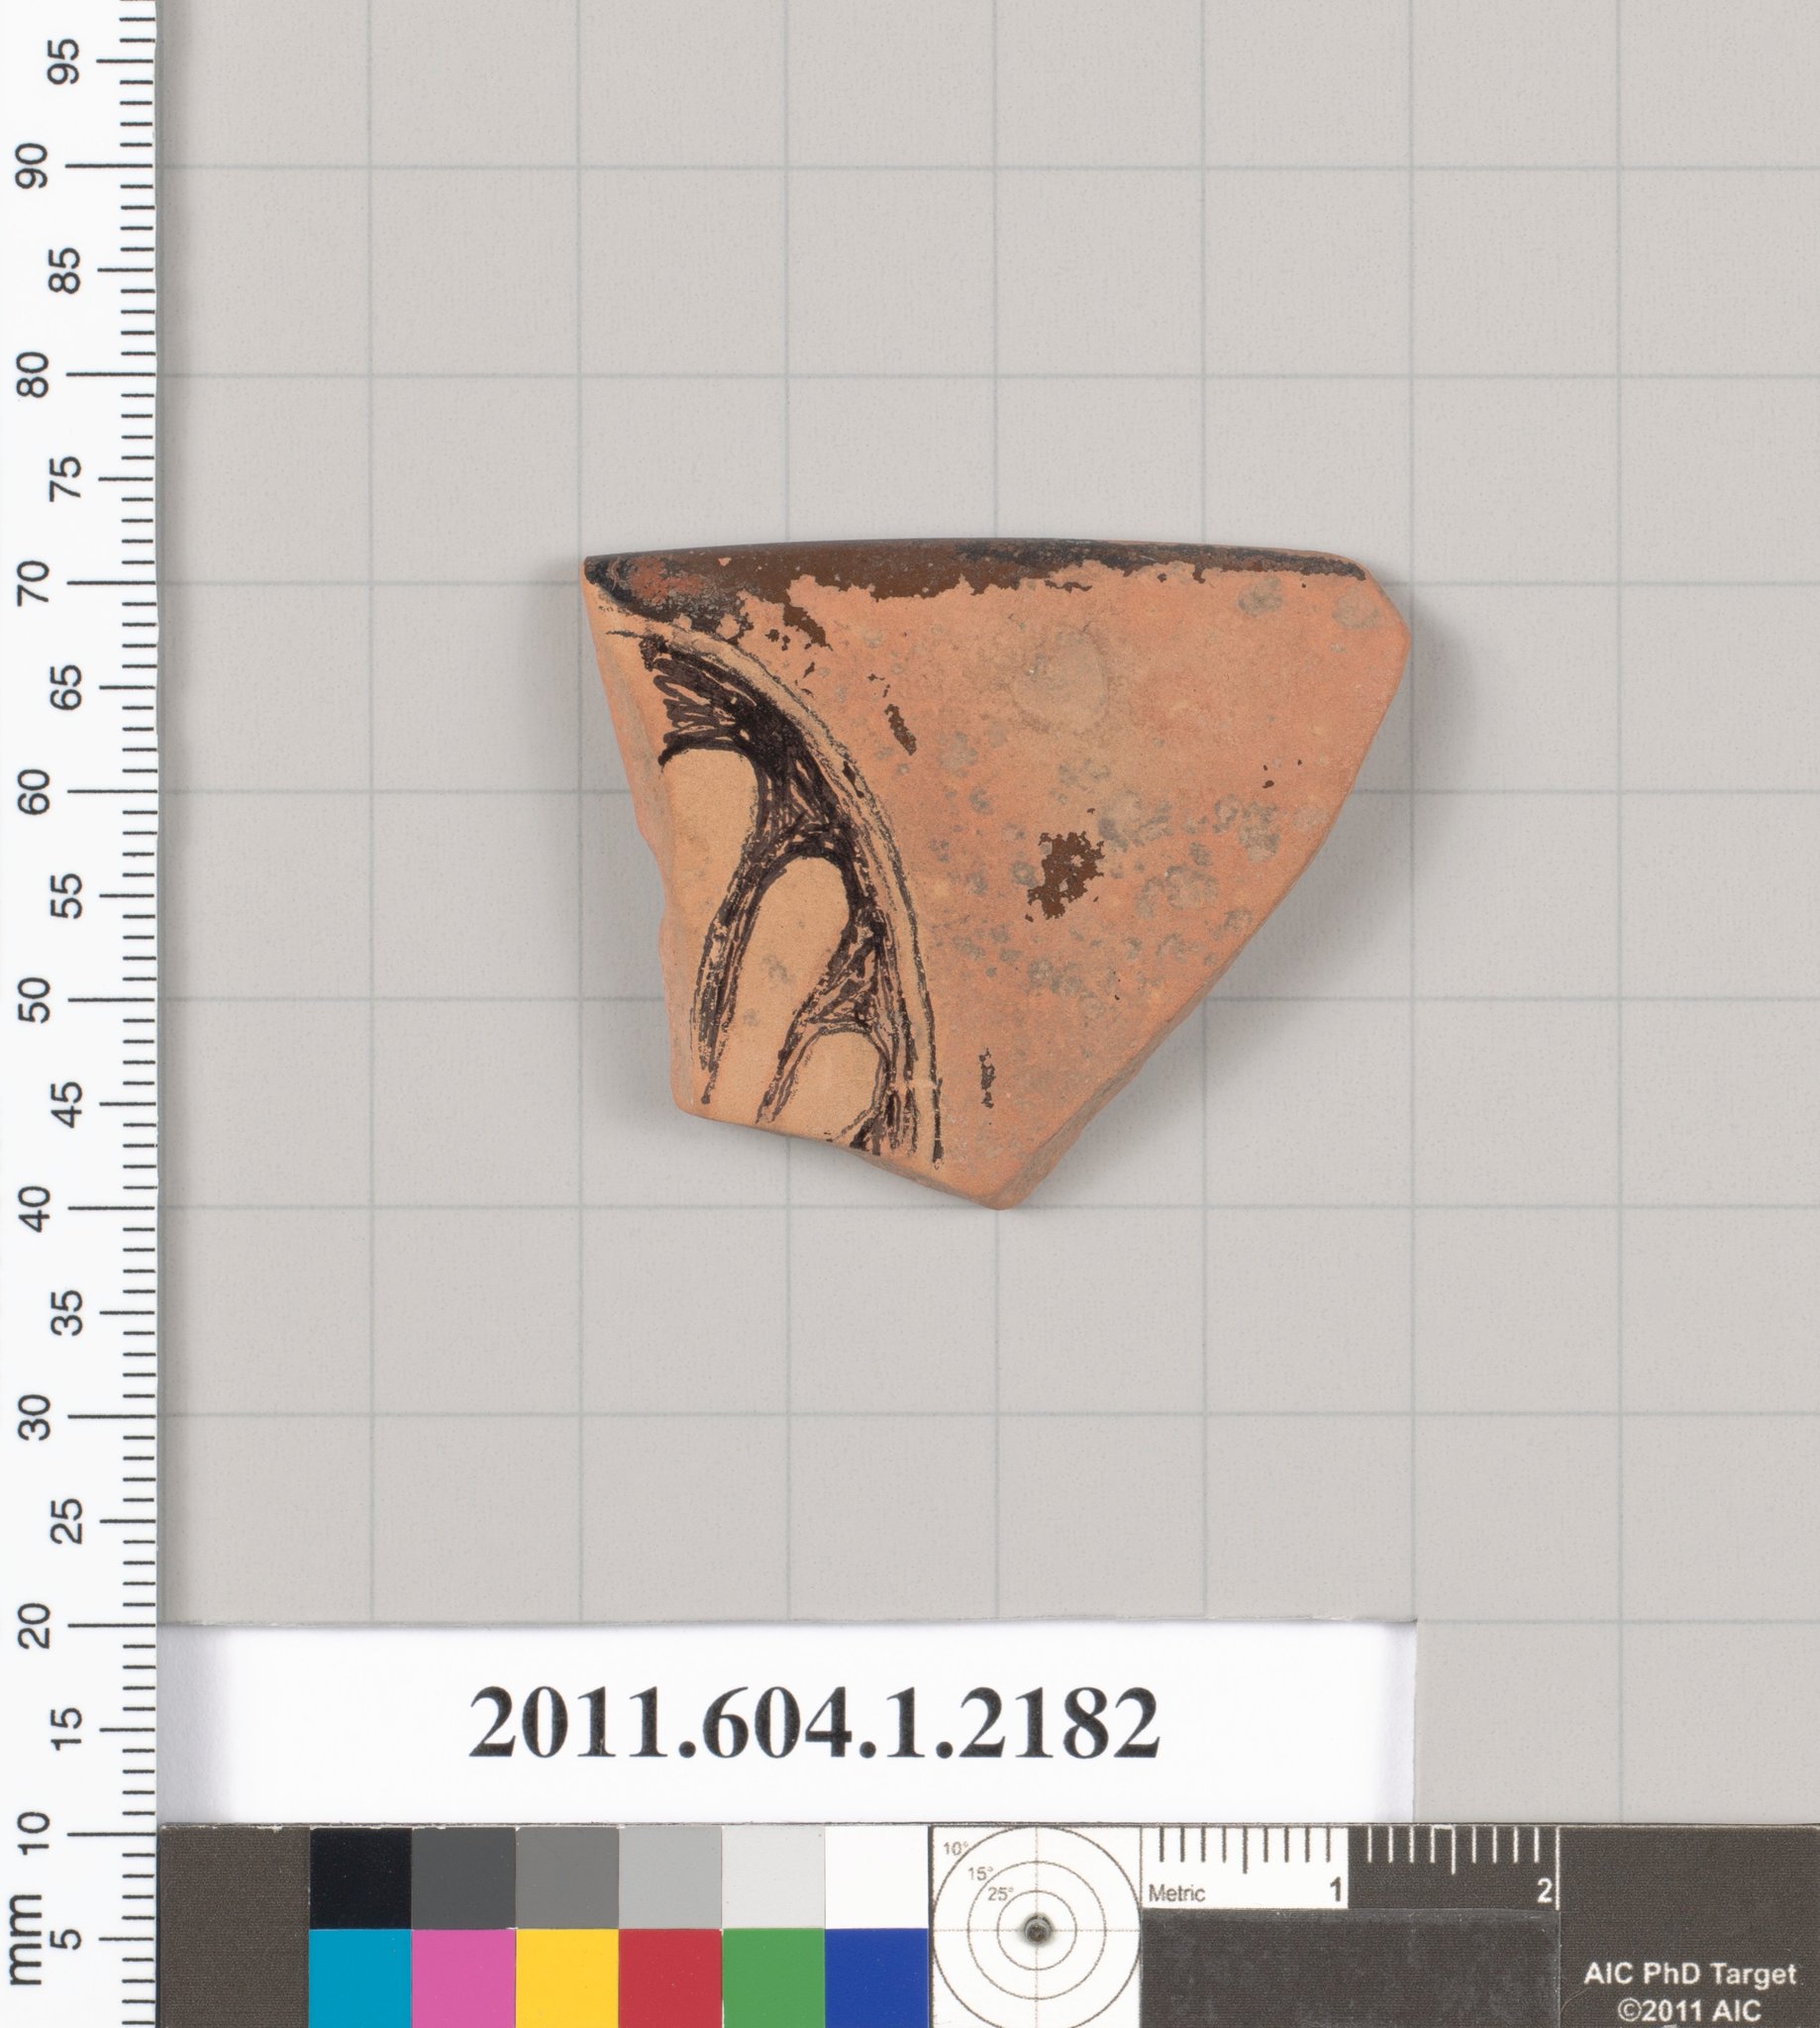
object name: kylix fragment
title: Terracotta rim fragment of a kylix (drinking cup)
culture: greek, attic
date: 500-476 BCE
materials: terracotta